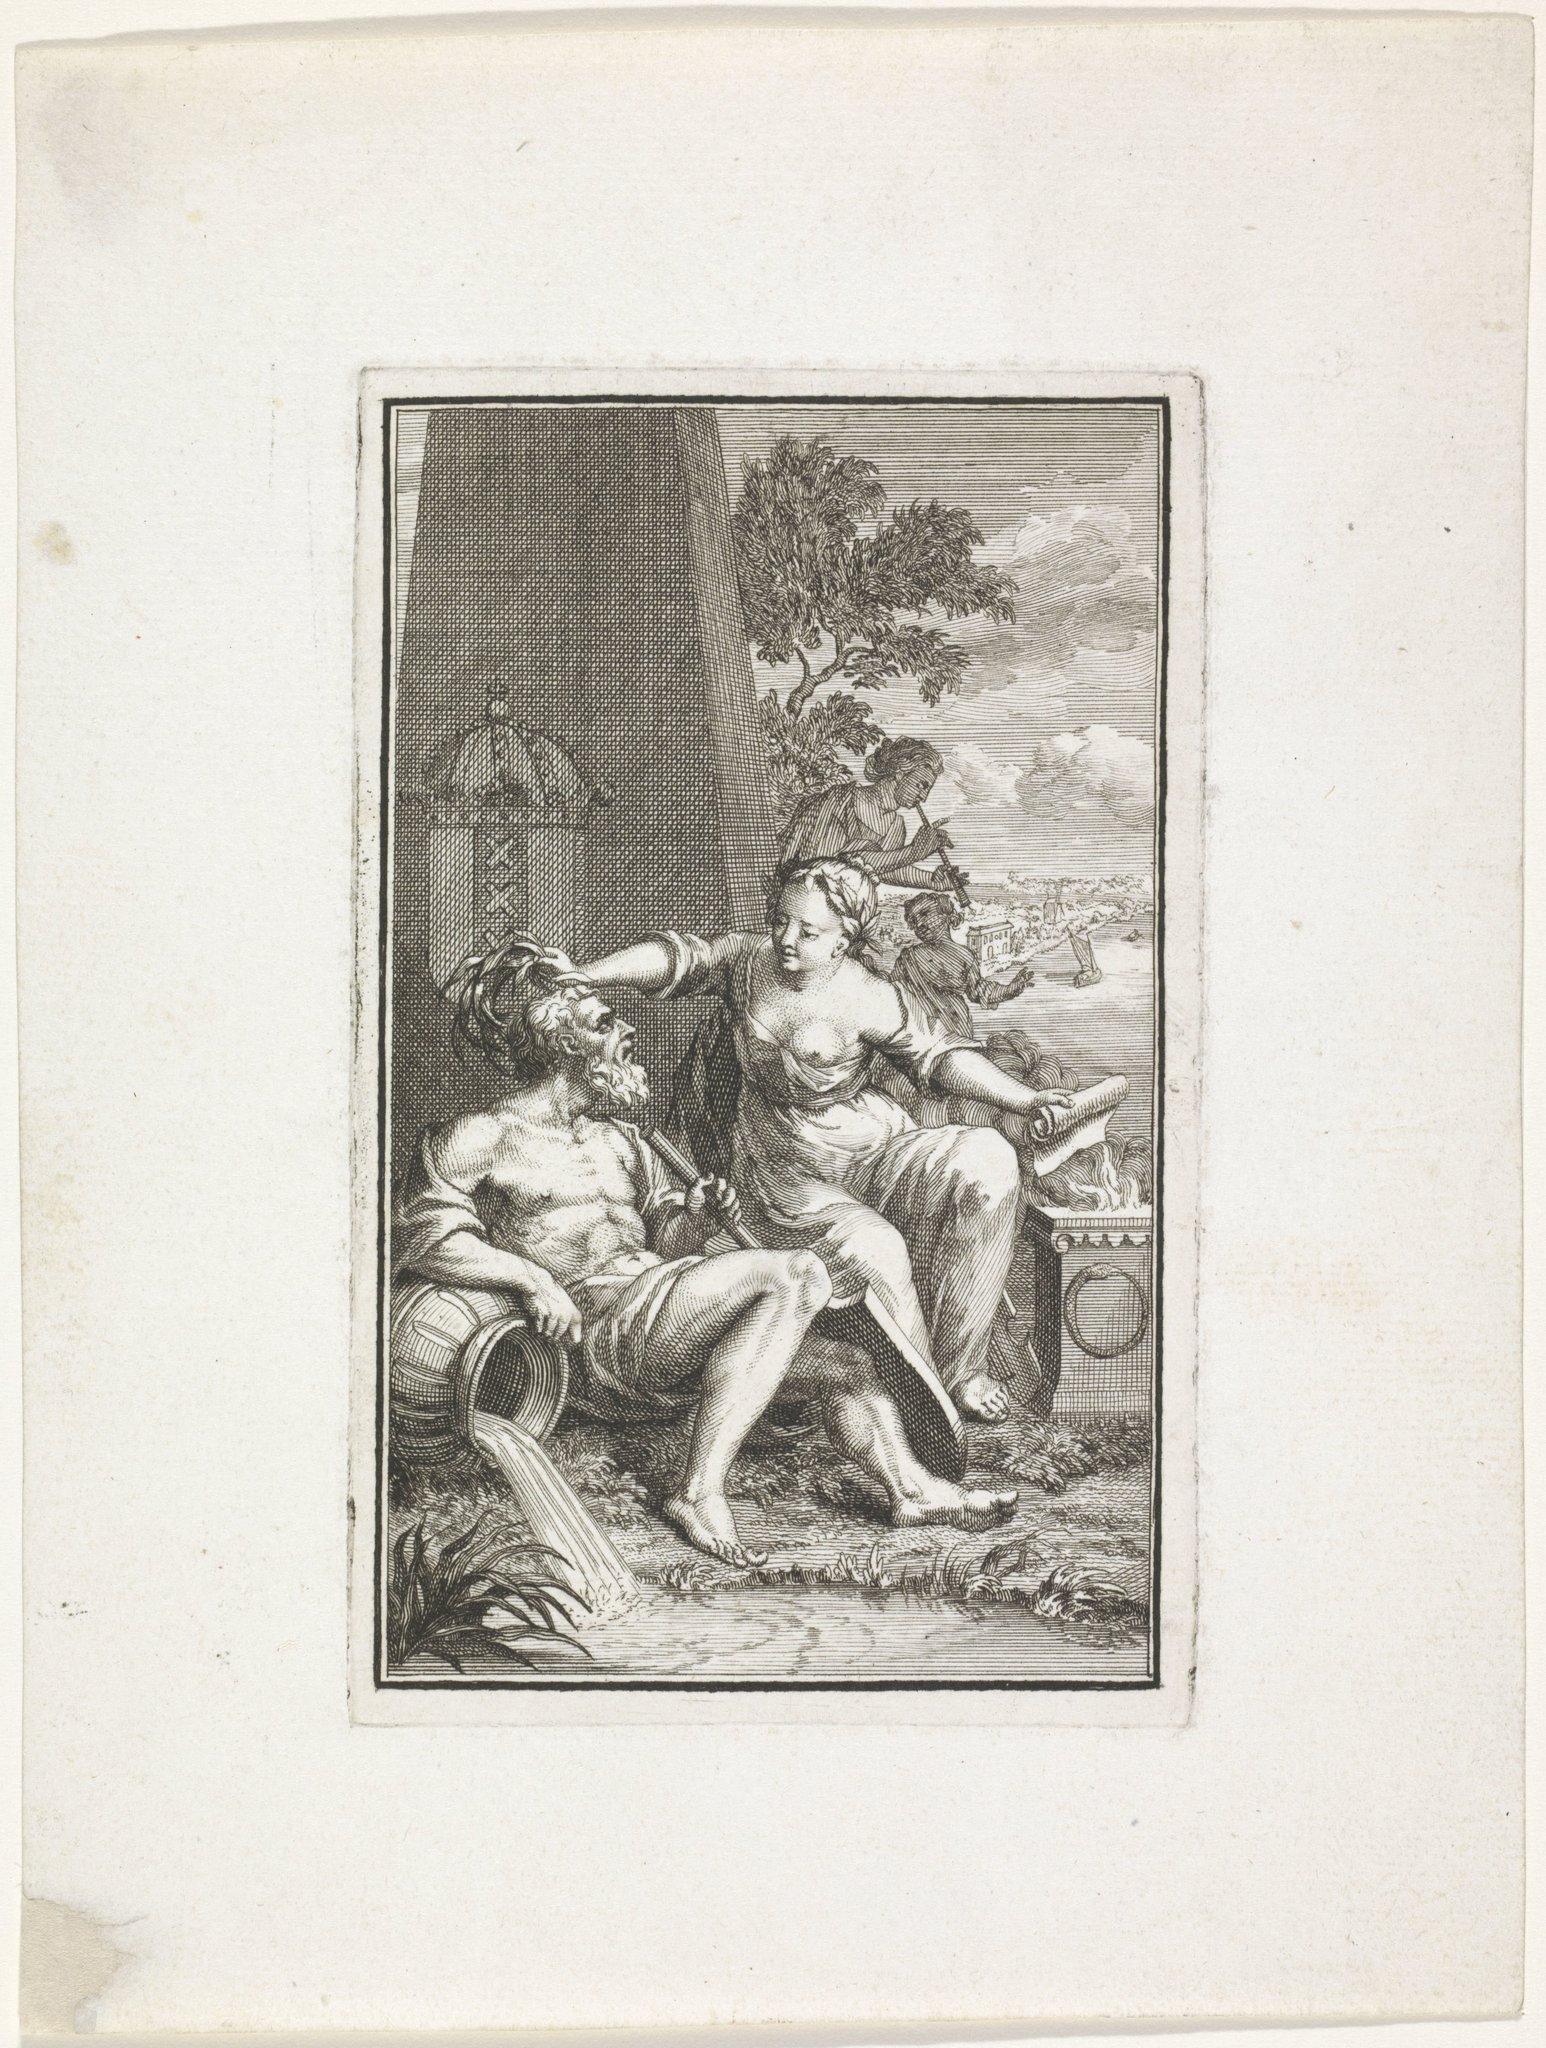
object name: print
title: Stroomgod van Amsterdam gelauwerd door een muze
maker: Anonymous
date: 1700-1800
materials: paper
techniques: engraving, etching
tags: river personified, 'fiumi' (ripa), crowning with laurel, single muses, amsterdam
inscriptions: collector's mark: Lugt 2228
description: De stroomgod van Amstel of IJ wordt met een laurierkrans gekroond door een muze. Ze houdt een rol papier in de hand boven het vuur van een offerzuil. Op een monument het wapen van Amsterdam.